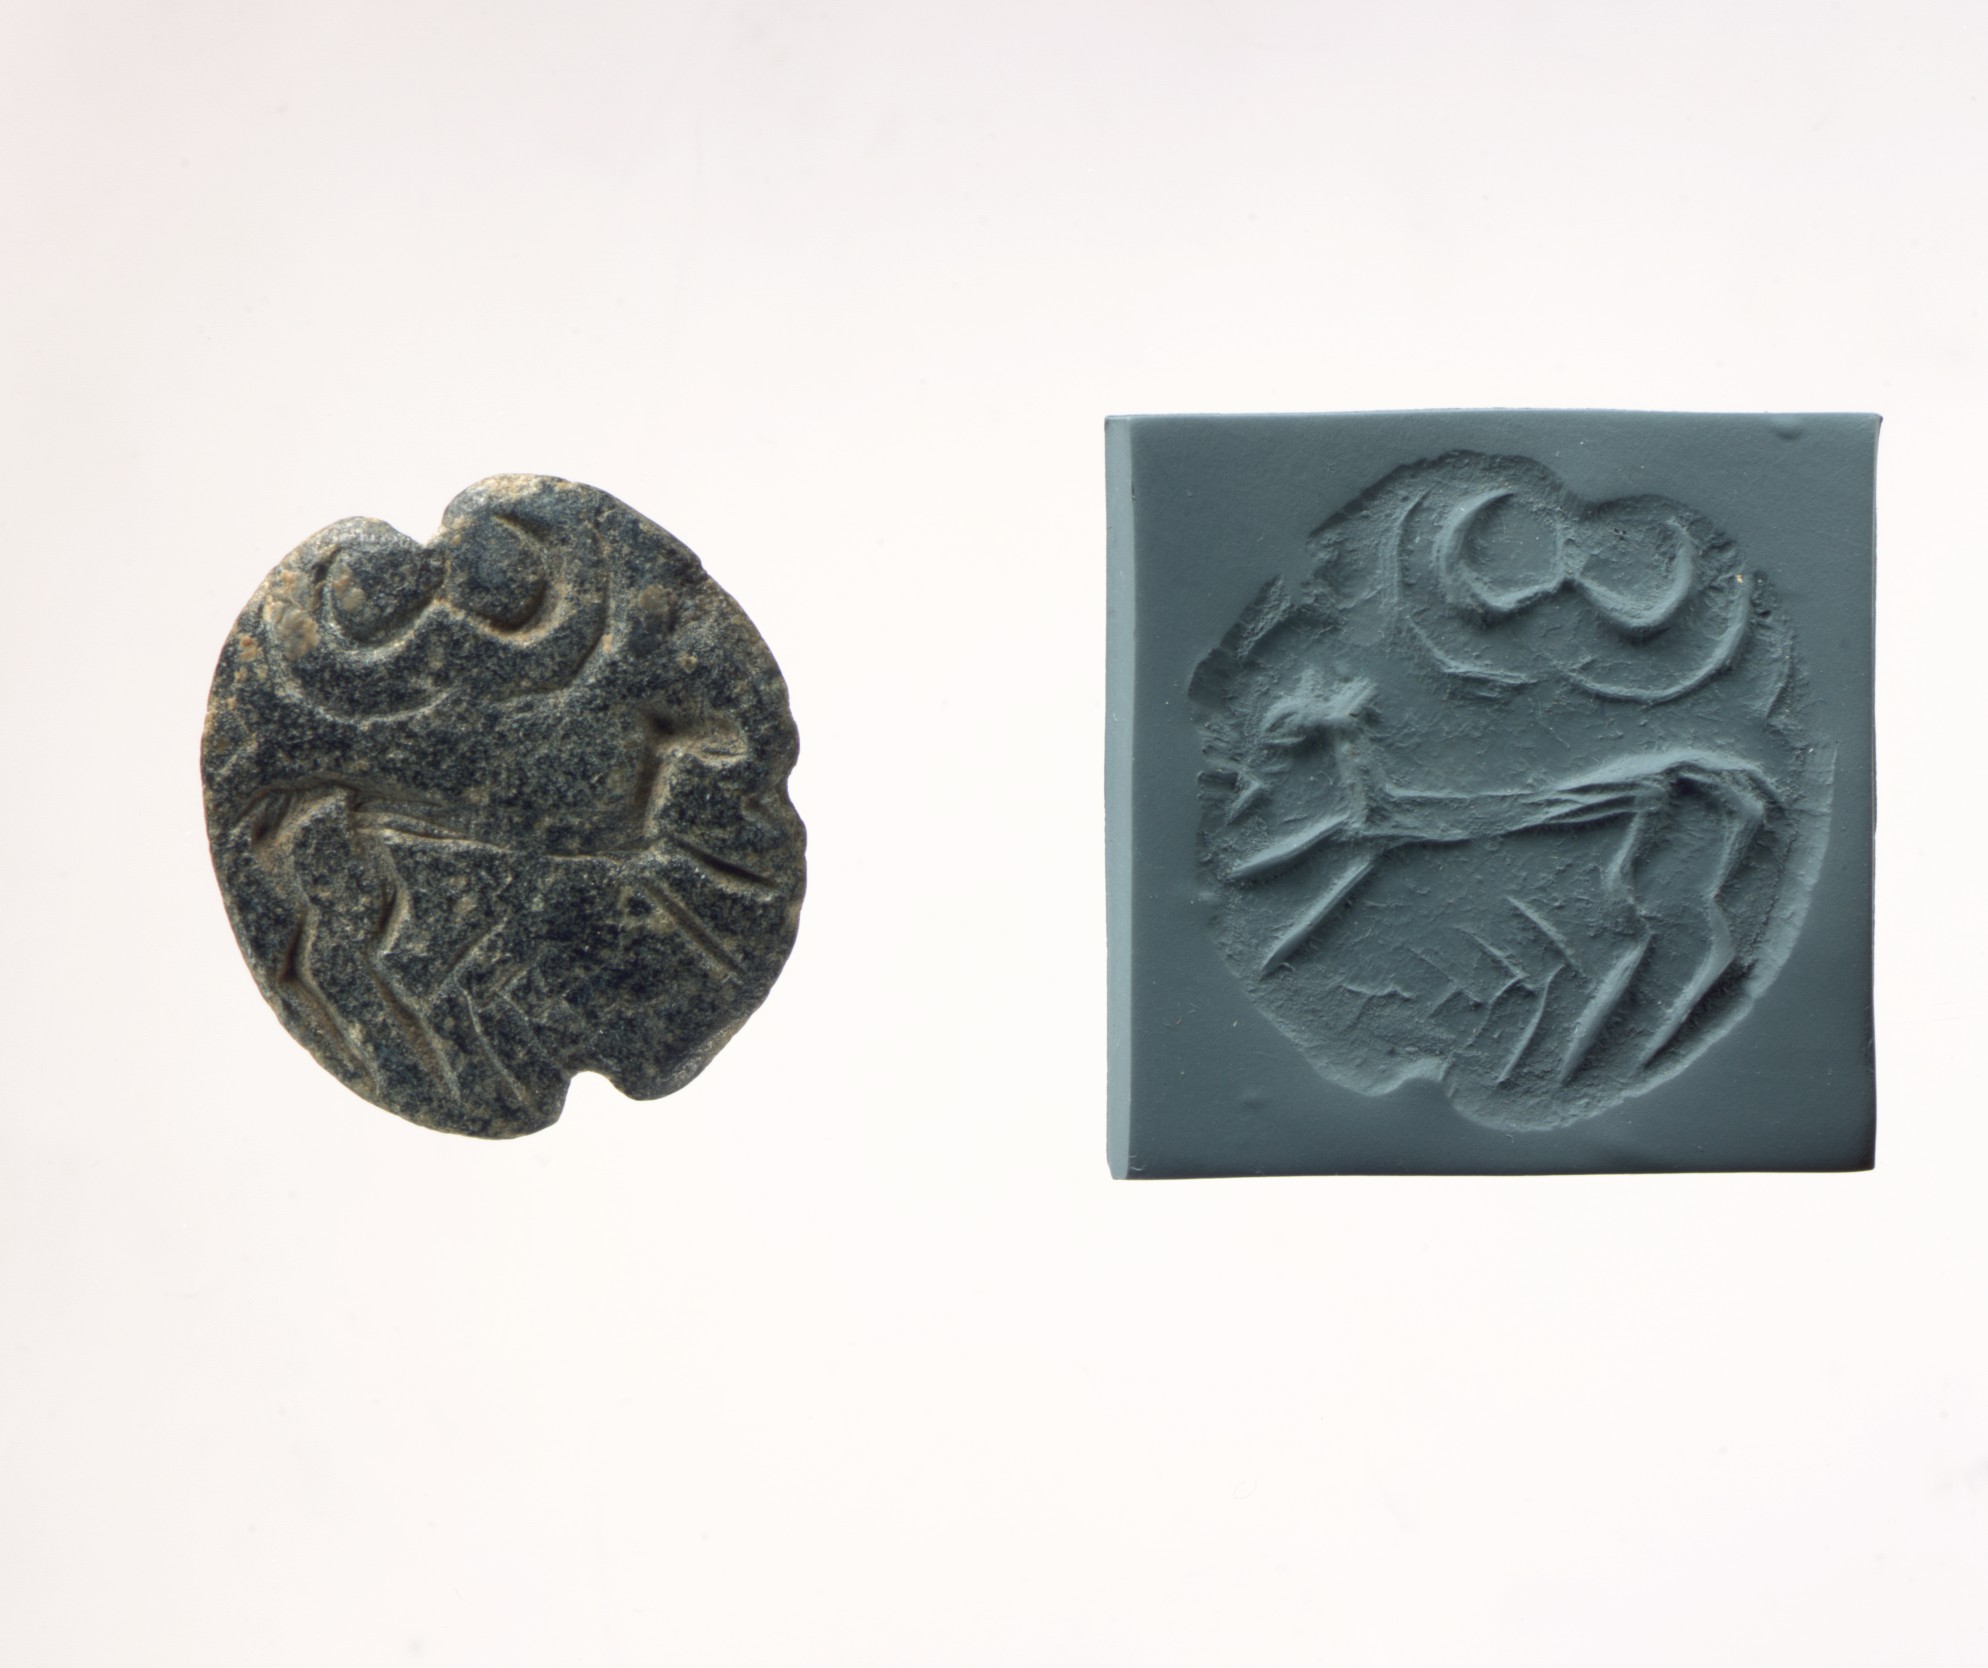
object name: stamp seal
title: Stamp seal and modern impression: quadruped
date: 4500-3500 BCE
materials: mineral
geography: northern syria or eastern anatolia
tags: animals